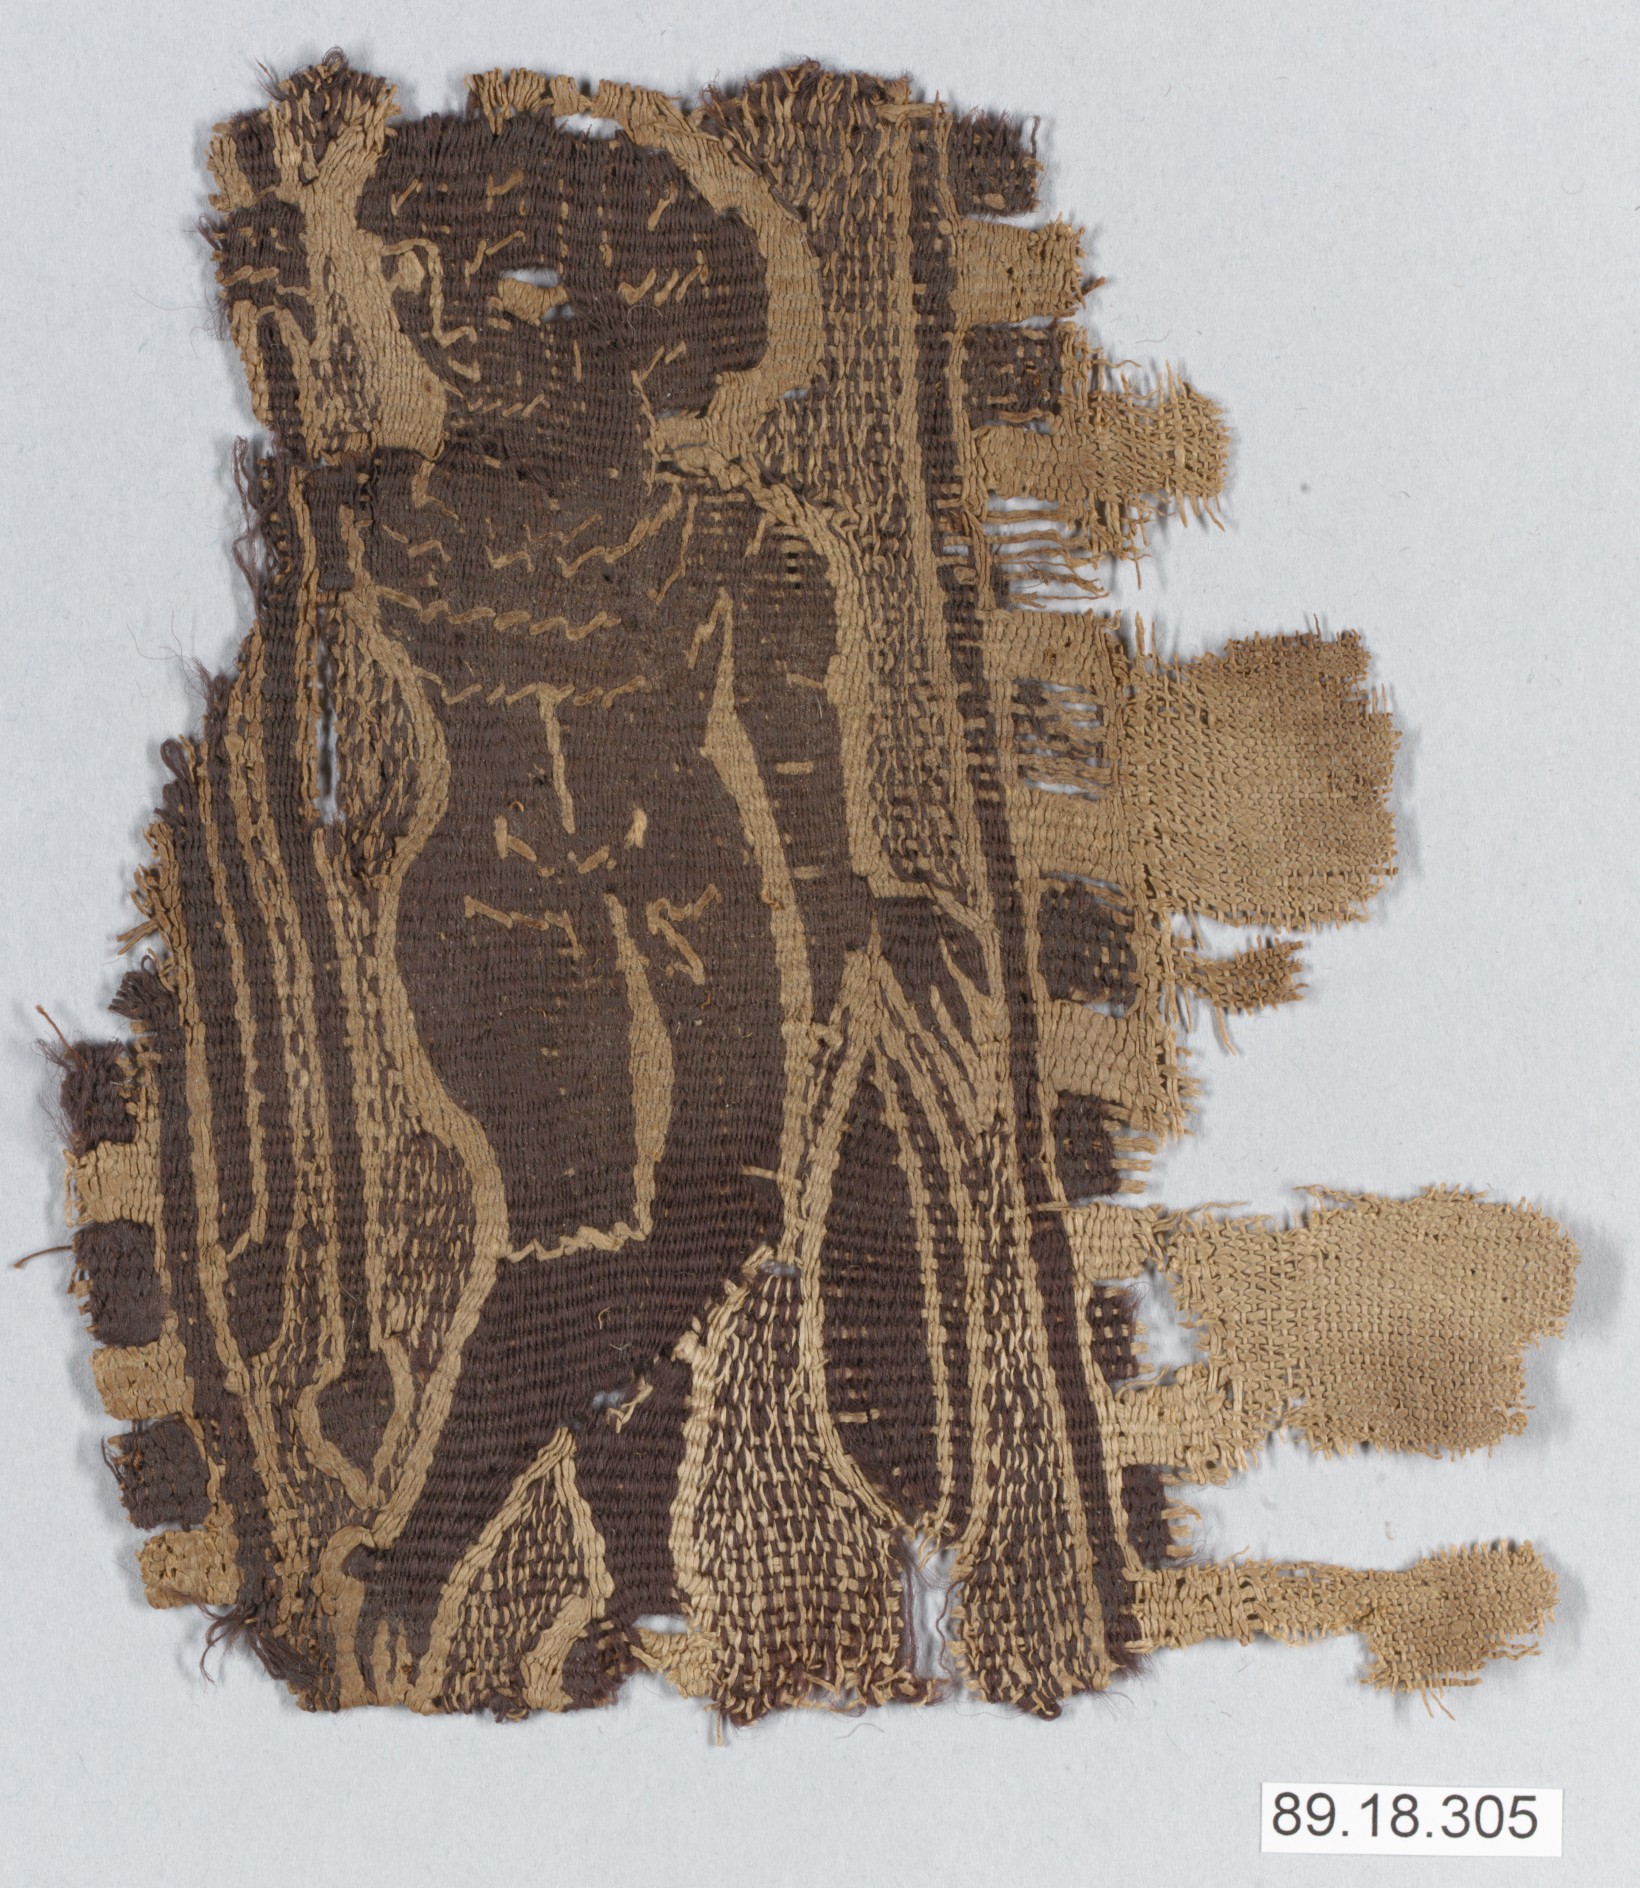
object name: textile fragment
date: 201-400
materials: linen, wool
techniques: weave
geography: egypt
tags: warriors